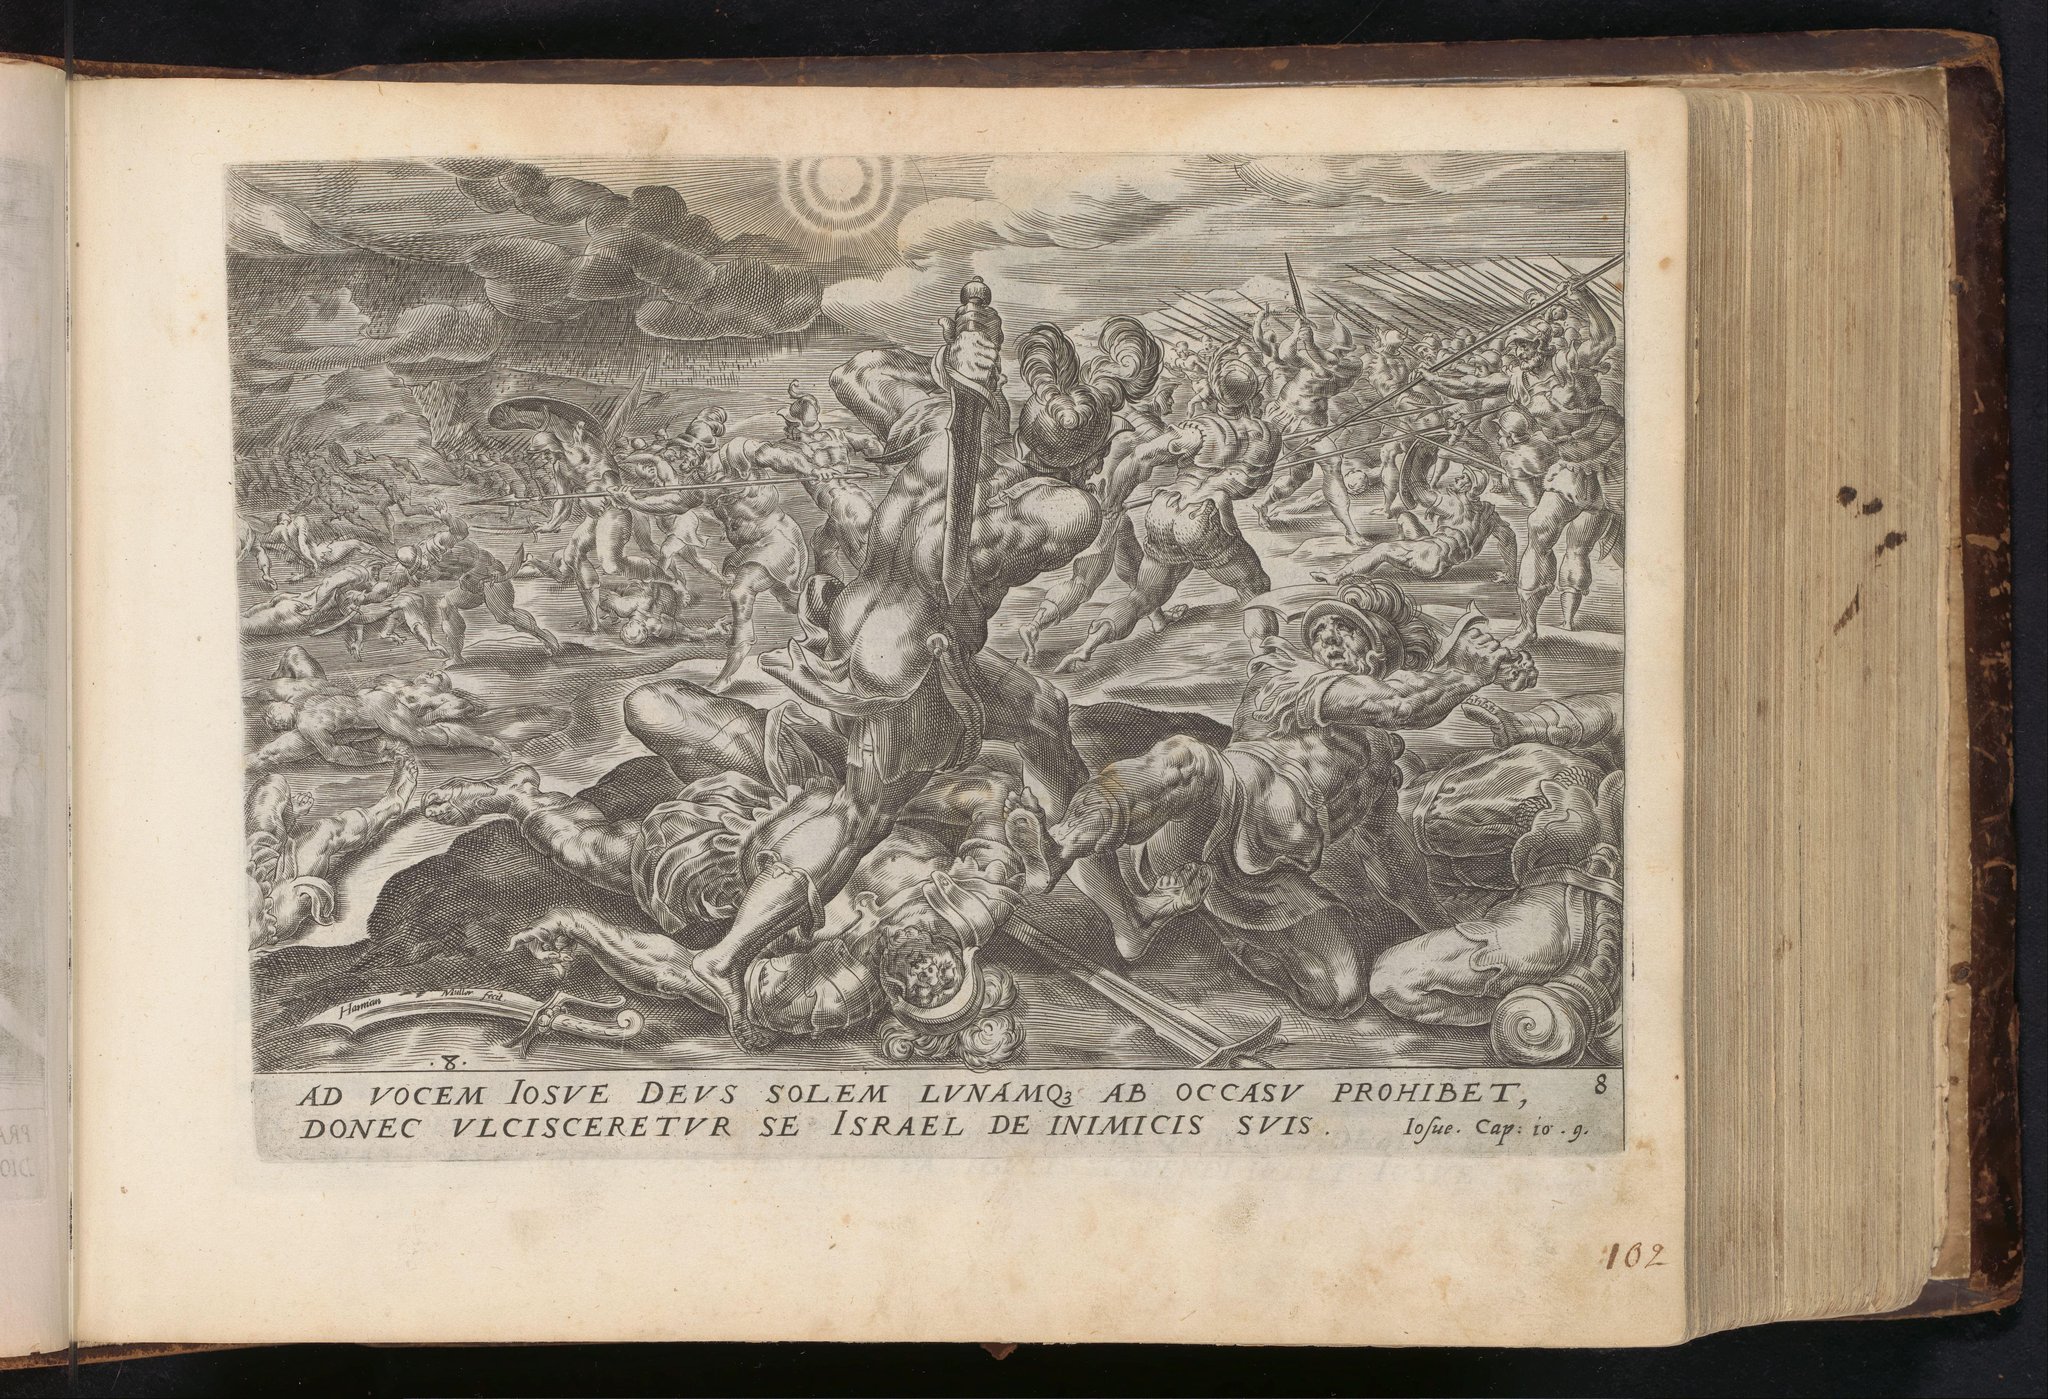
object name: print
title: De geschiedenissen van Iosua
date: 1646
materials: paper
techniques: engraving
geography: alkmaar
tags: joshua and his army make a surprise attack on the amorites who are besieging the city of gibeon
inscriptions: number: ‘102’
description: De Israëlieten strijden tegen de legers van vijf Amoritische koningen. De zon schijnt een volle dag aan de hemel en hagelstenen verdrijven de vijand. Onder de voorstelling een verwijzing in het Latijn naar de Bijbeltekst in Joz. 10:9. Deze prent maakt deel uit van een album.